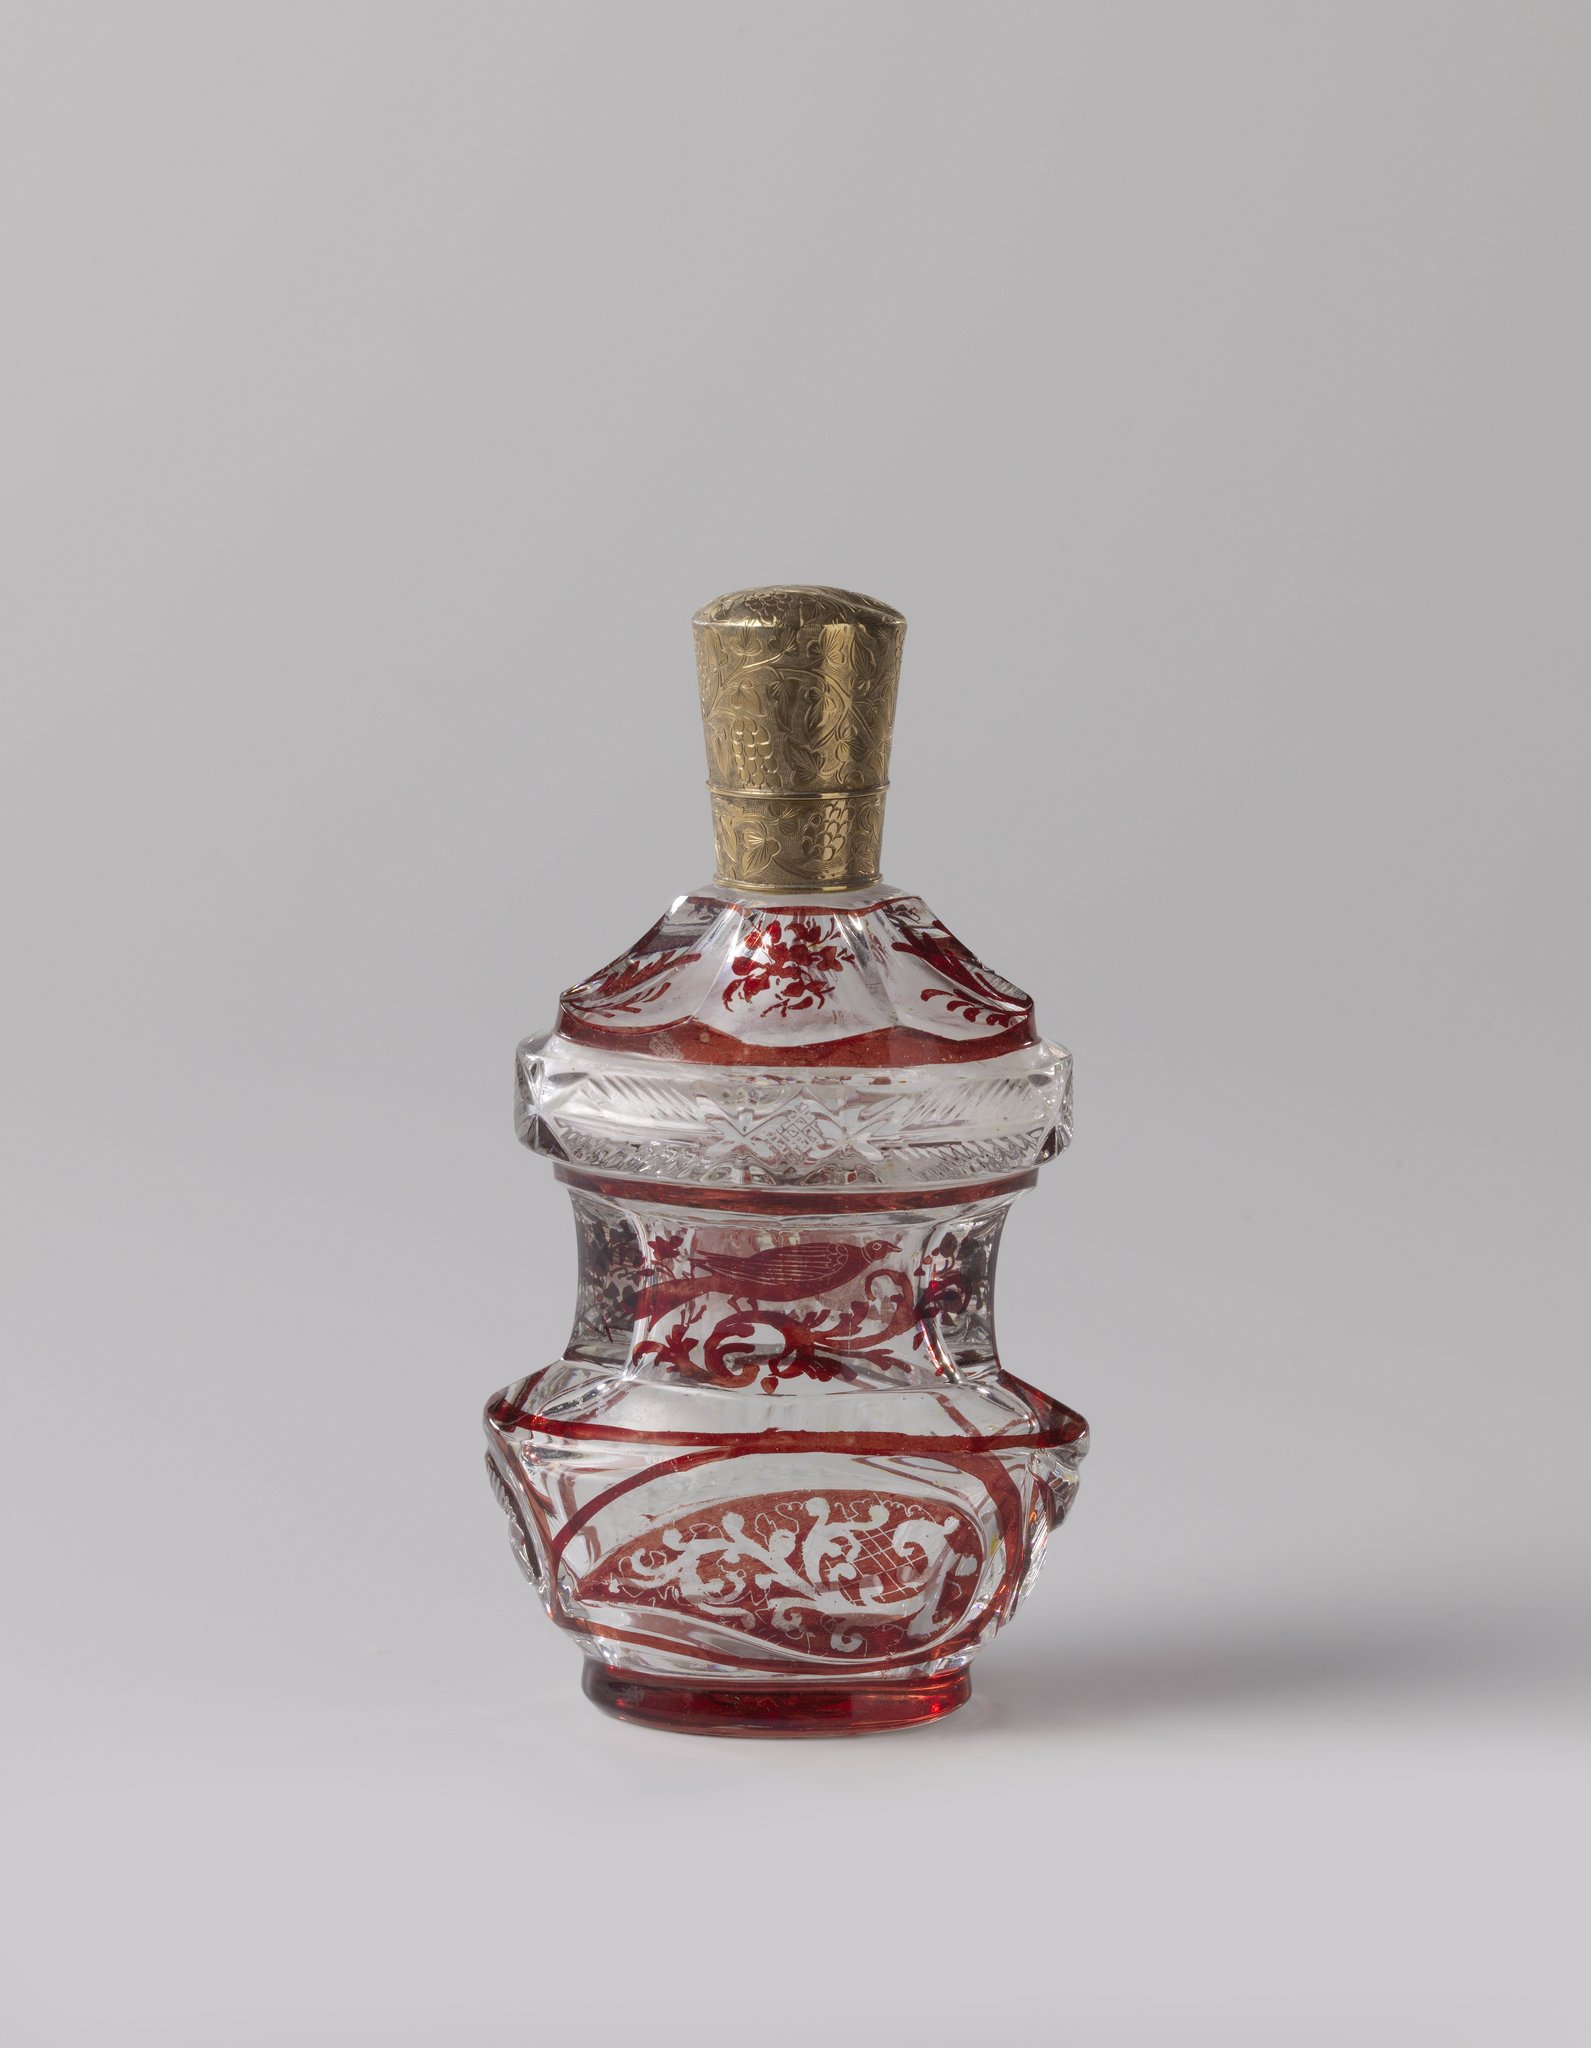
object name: flacon, flakon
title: Flacon met visblazen, vogels en bloemen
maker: Anonymous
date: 1850-1900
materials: glass, gold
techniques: glassblowing, grinding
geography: bohemia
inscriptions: alloy mark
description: Plat standvlak, ovaal, in het midden ingesnoerd lichaam, facetgeslepen, visblazen, vogels, bloemen en bladornament. Kleine, platte stop van glas. De hals gevat in een montuur van goud met een hoge, ronde deksel, gegraveerd met bloemranken.